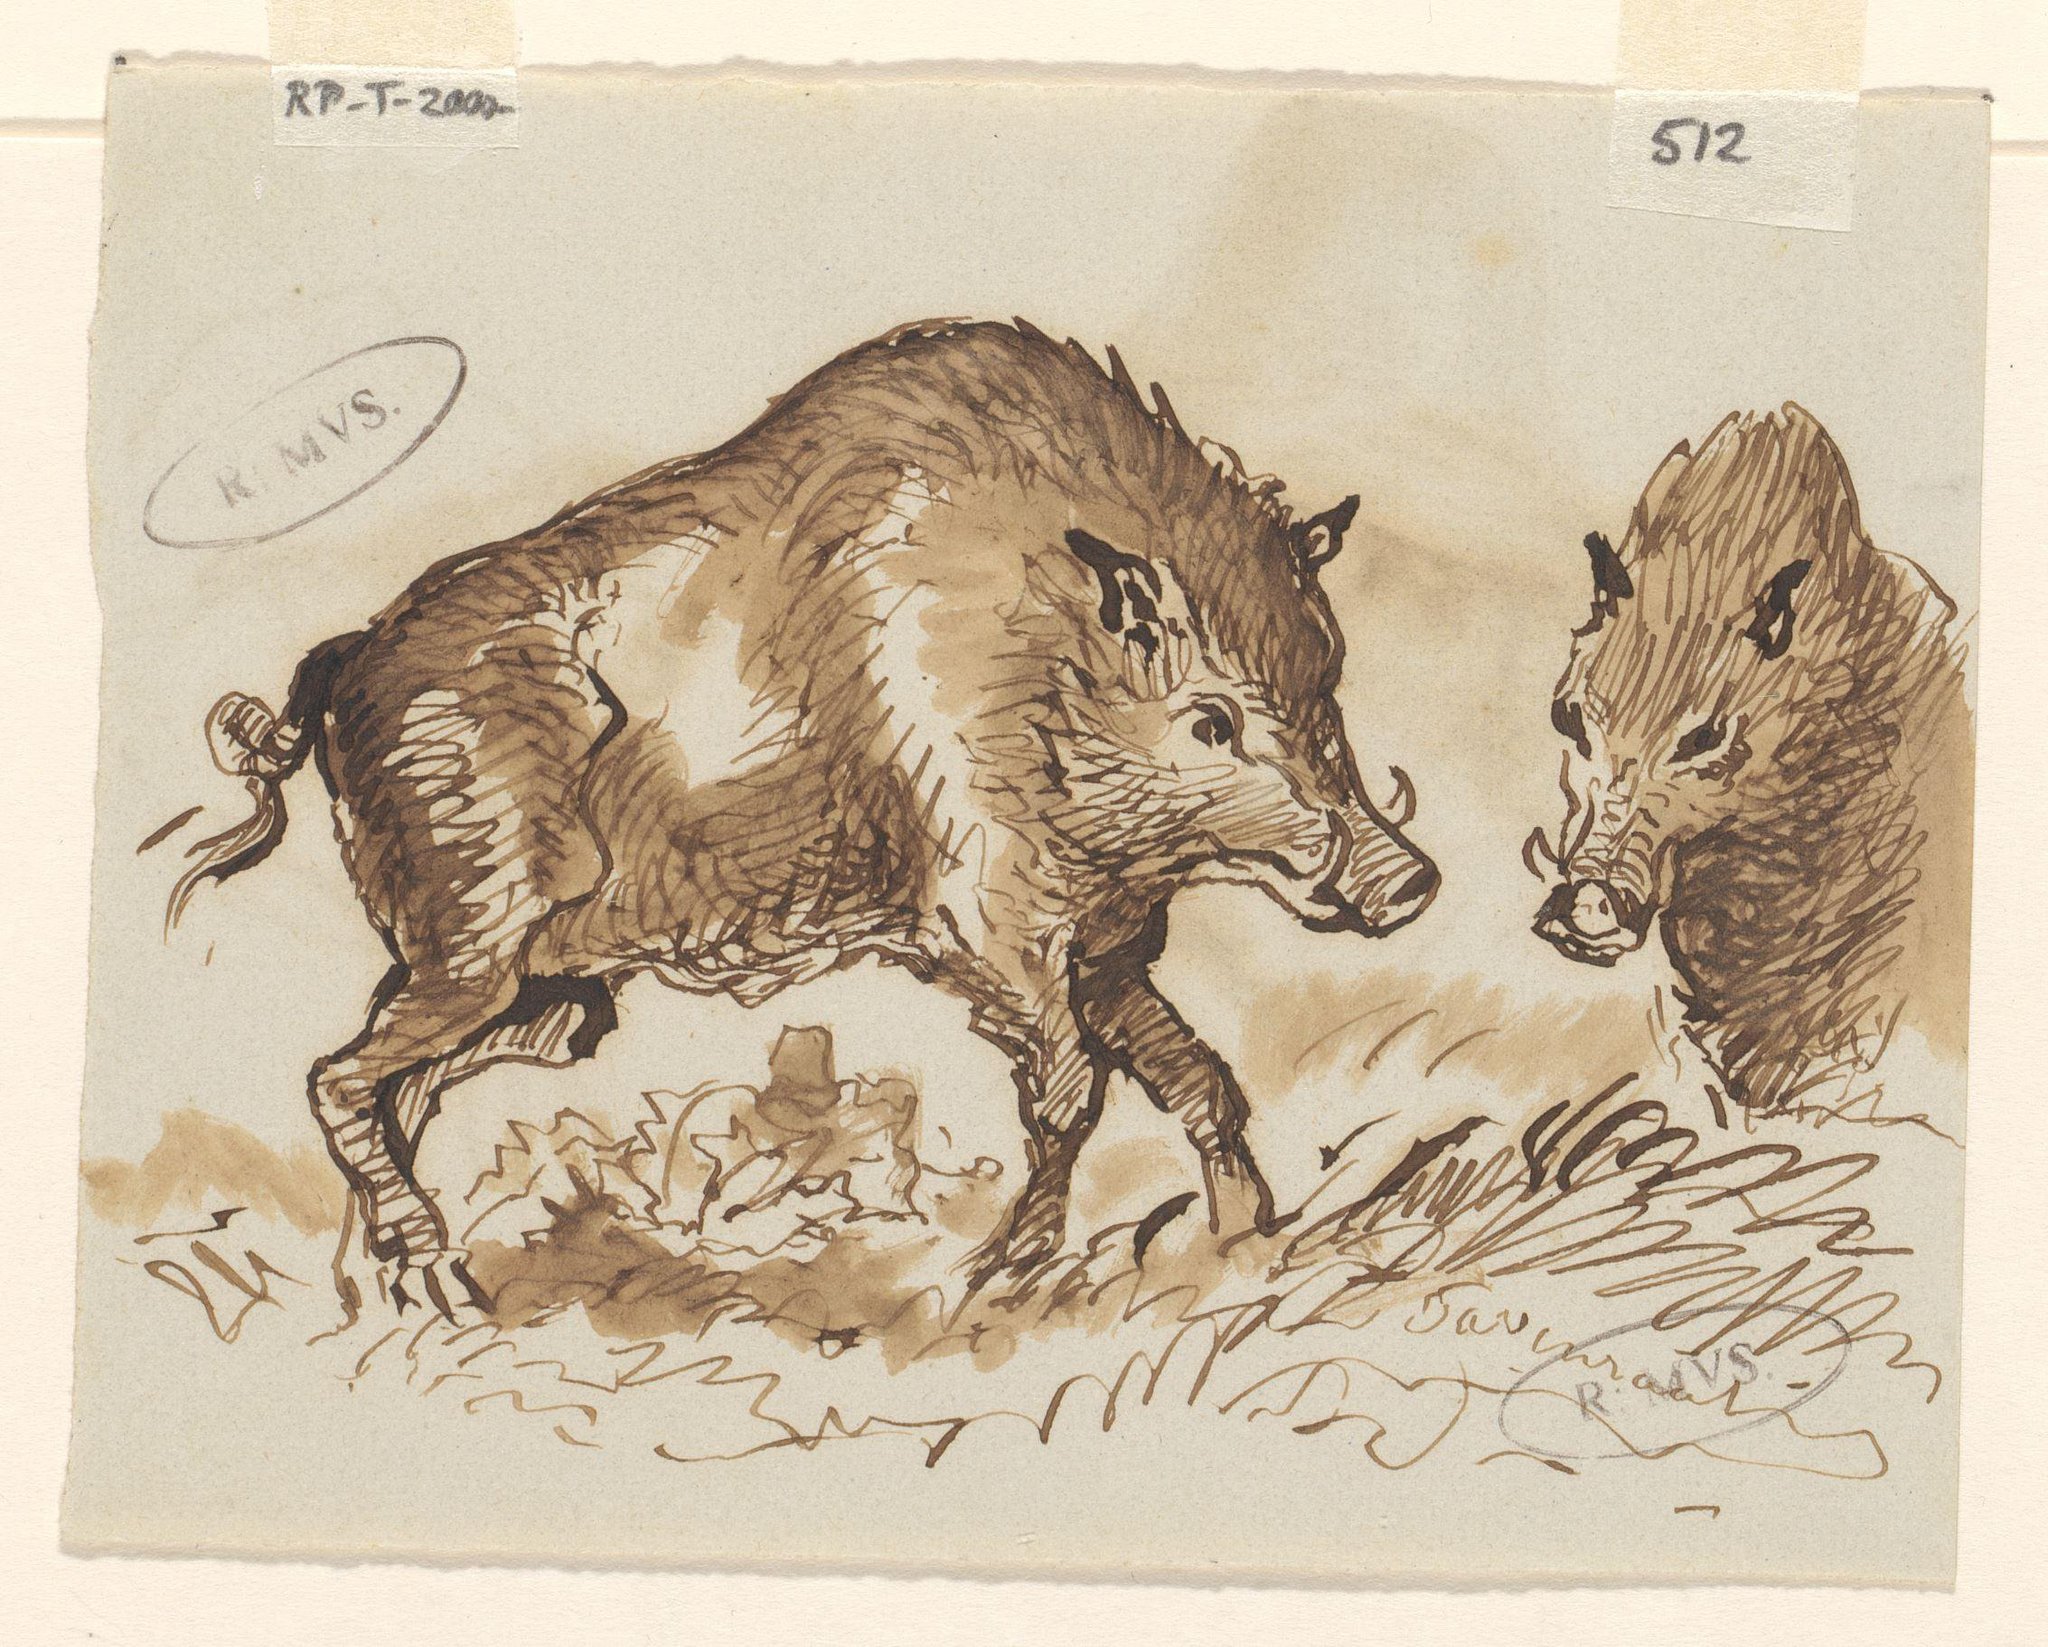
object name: drawing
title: Wilde zwijnen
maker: johannes tavenraat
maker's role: draughtsman, painter, print maker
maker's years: 1809-1881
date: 1840-1880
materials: ink, paper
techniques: brush, pen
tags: hoofed animals: boar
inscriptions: collector's mark: Lugt 2228, signature: ‘Tavenraat’